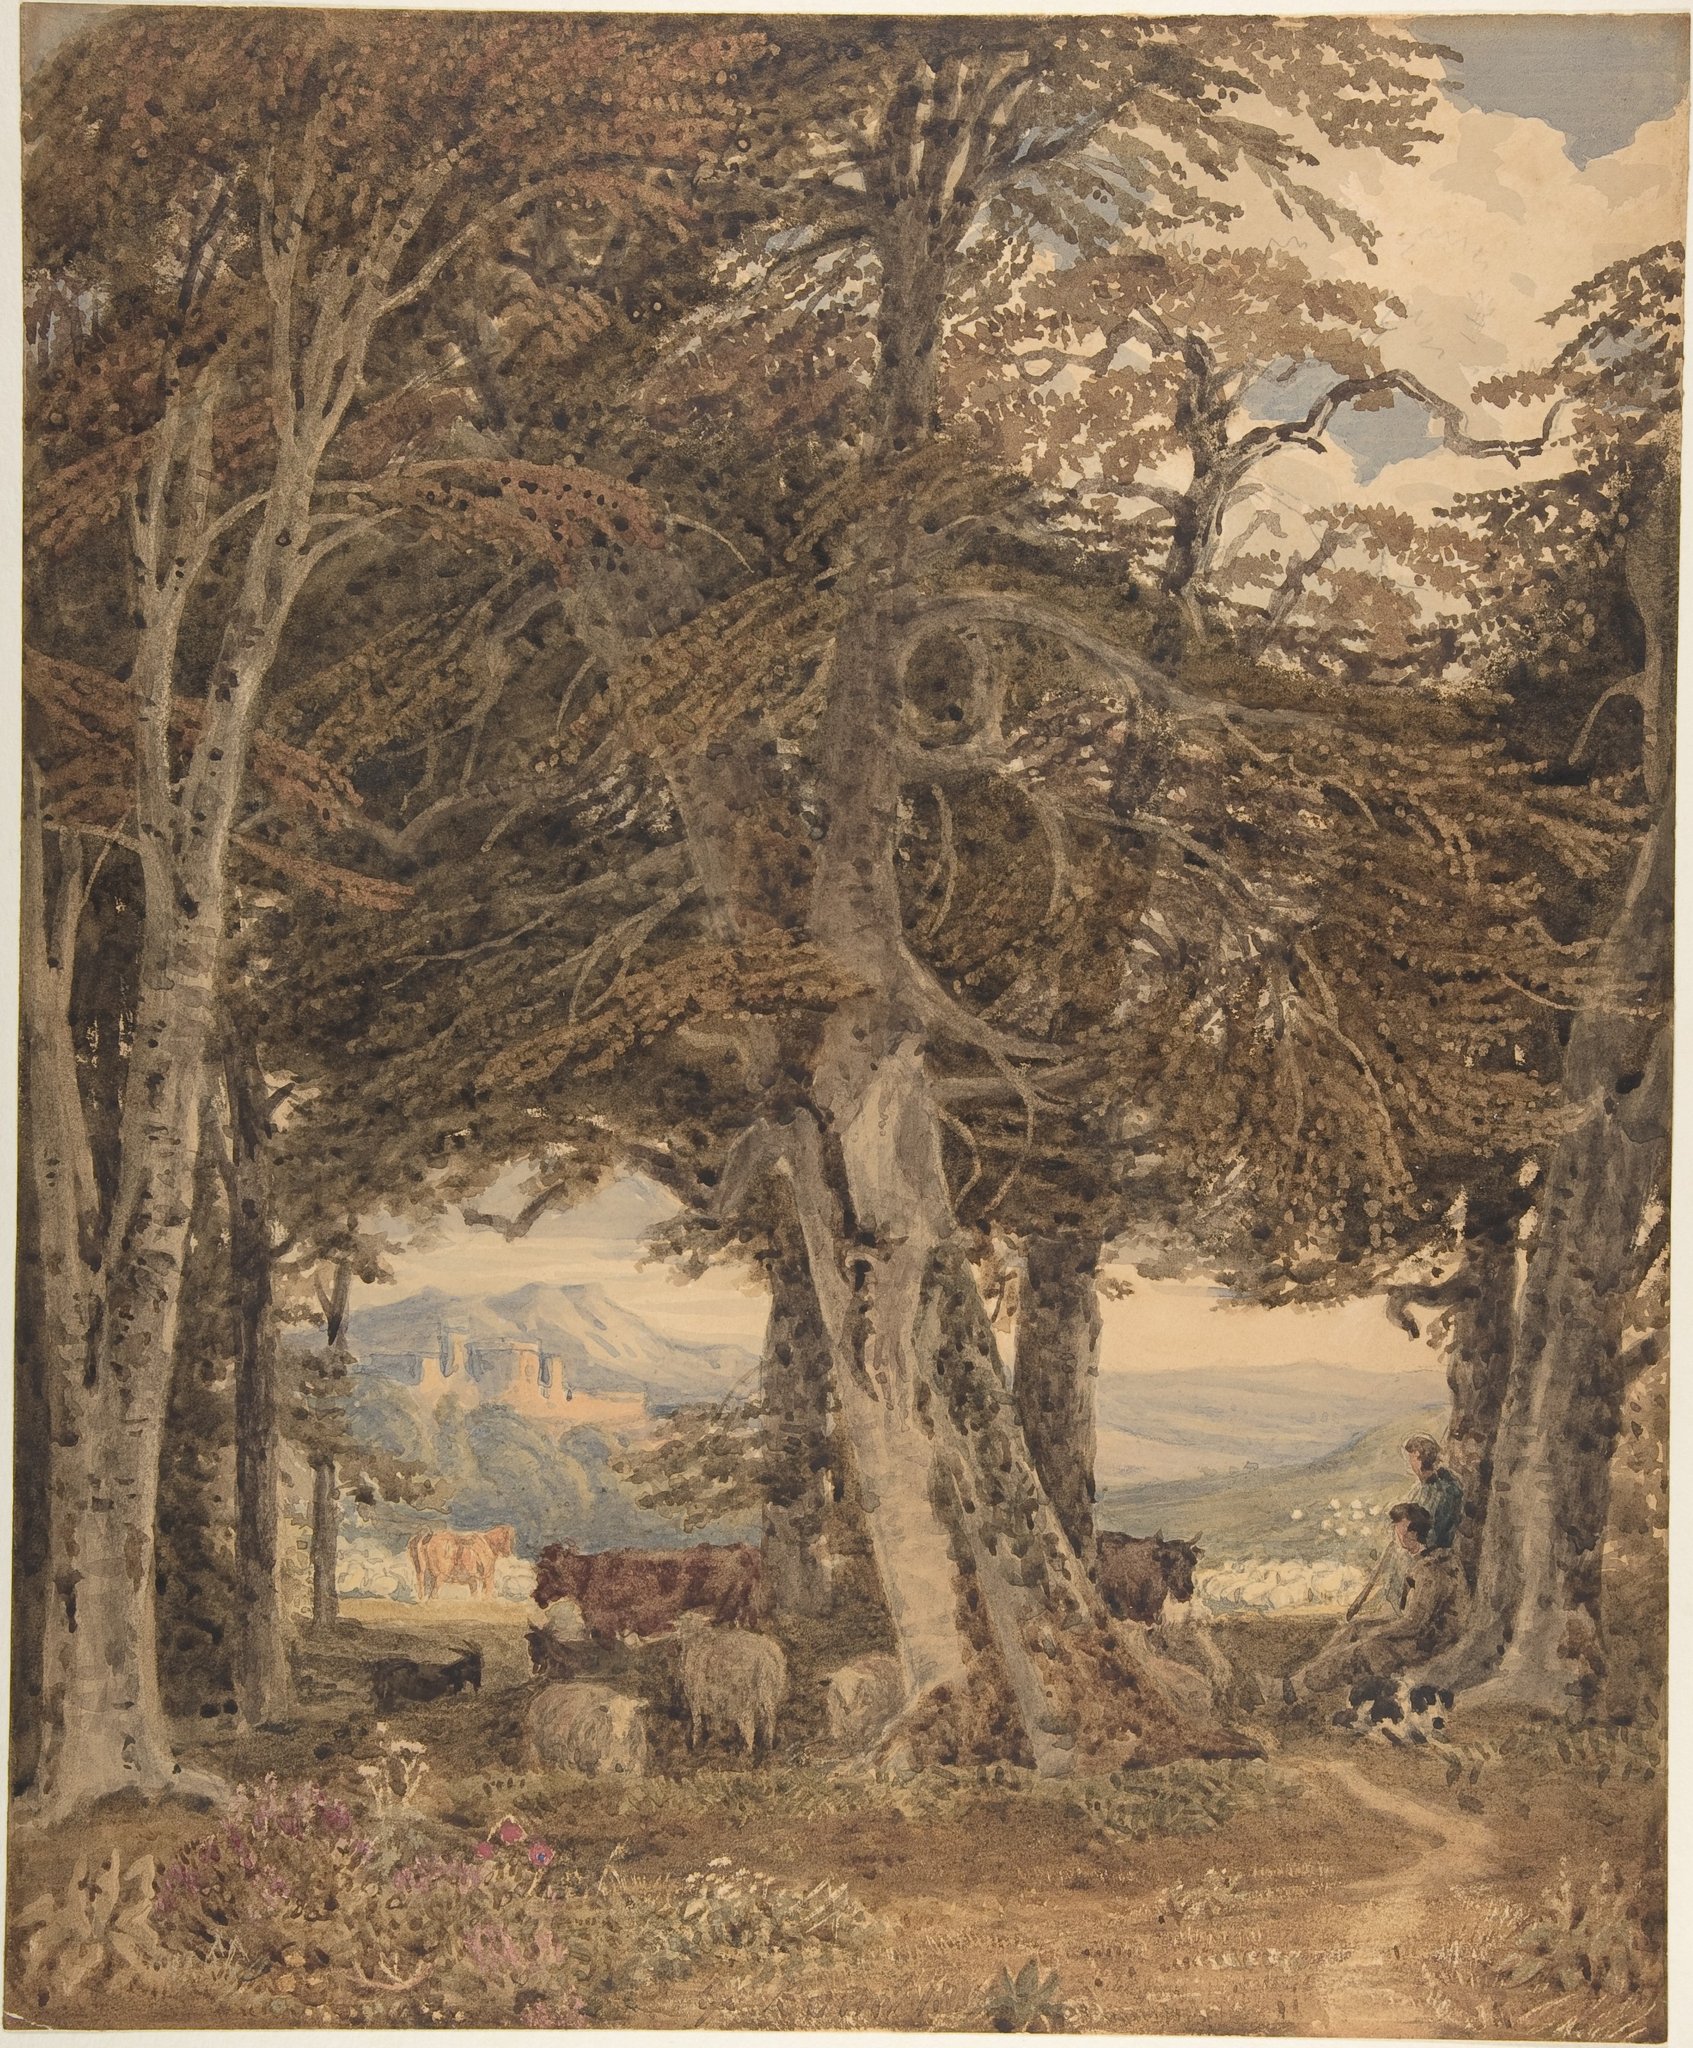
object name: drawing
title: Cattle and sheep at resting at the edge of a forest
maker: george barret, the younger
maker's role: artist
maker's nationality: british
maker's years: 1767-1842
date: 1840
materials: gouache, graphite, gum arabic, watercolor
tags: cows,sheep,trees